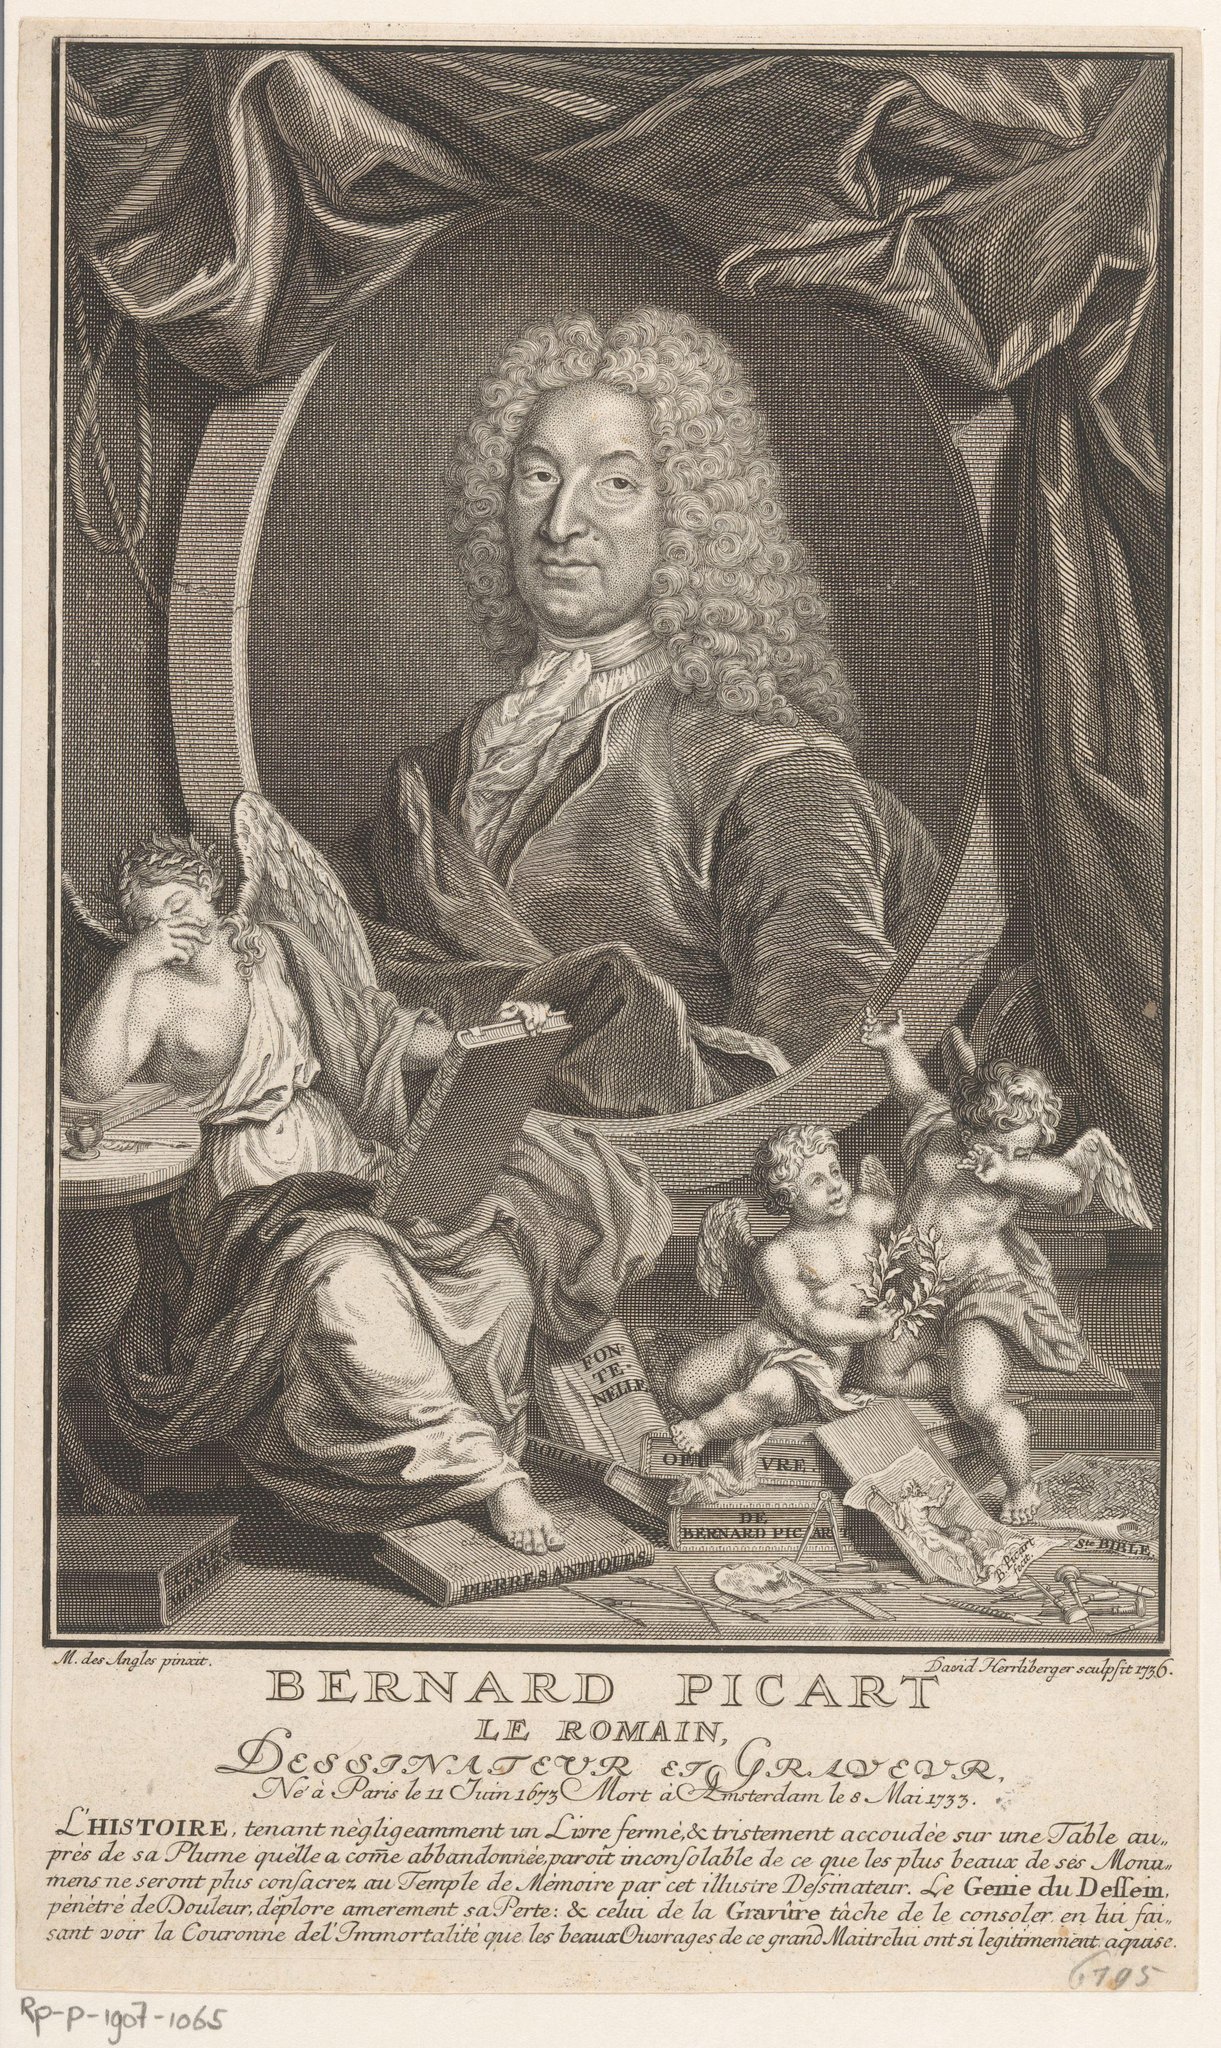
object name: print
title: Portret van Bernard Picart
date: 1736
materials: paper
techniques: engraving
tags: paris, amsterdam, print maker, draughtsman, publisher, bernard picart, honouring the artist with laurel wreath, writing tools, historical persons, tools, implements of graphic artist, book, publishing, publisher, cupids: 'amores', 'amoretti', 'putti'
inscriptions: collector's mark: Lugt 2228